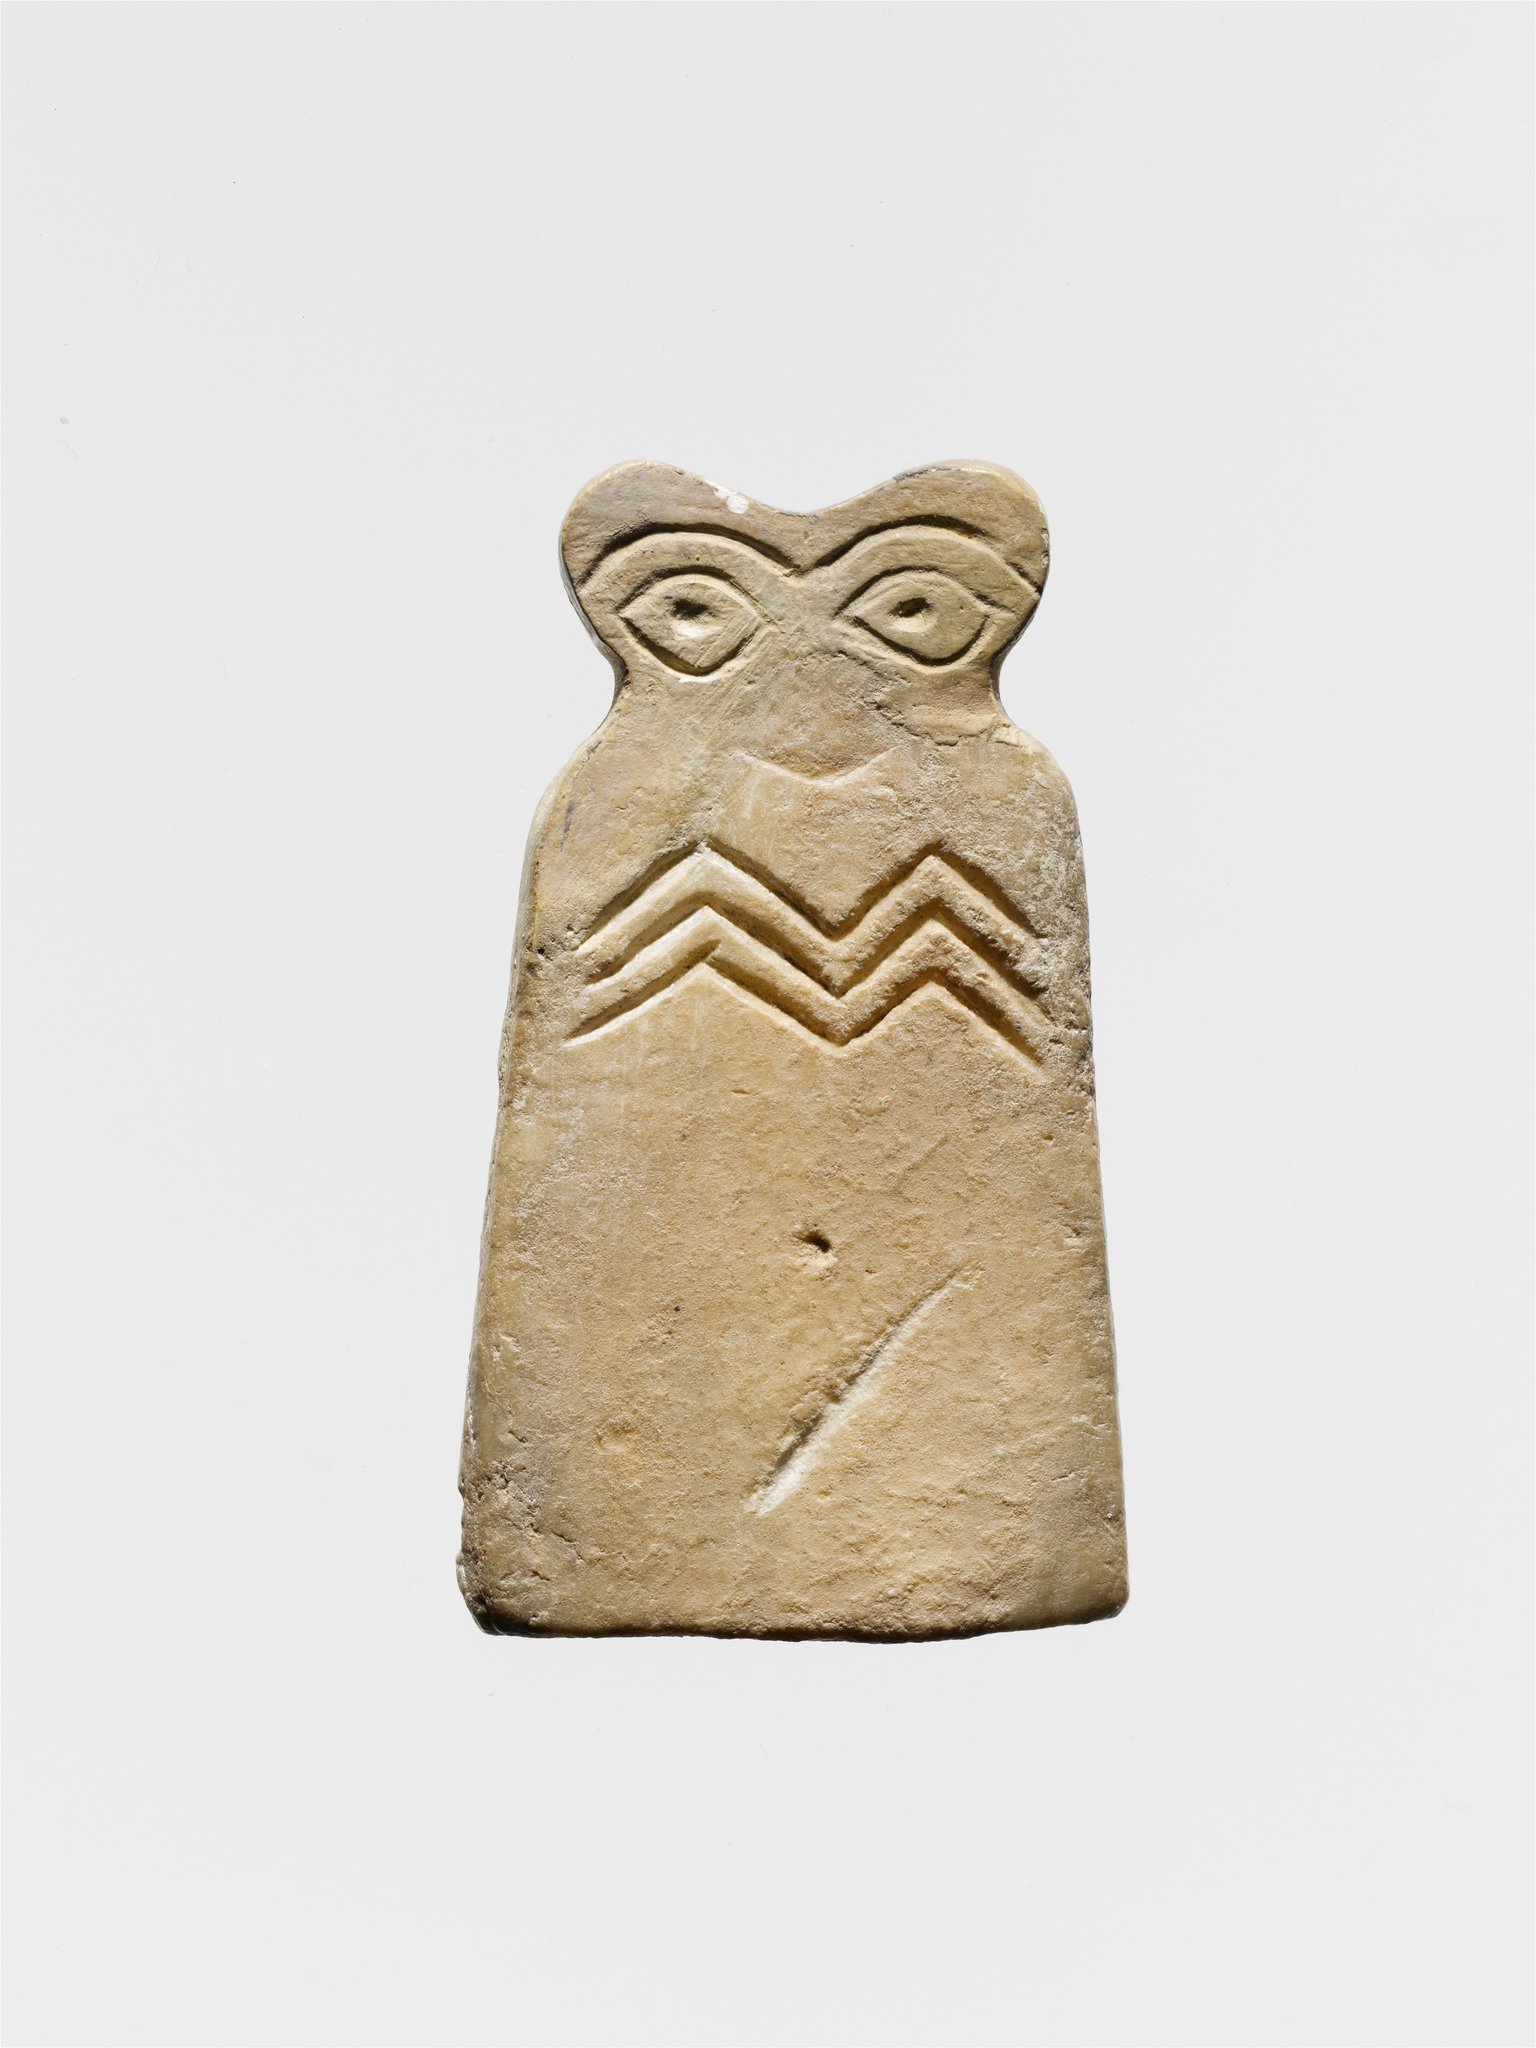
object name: sculpture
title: Eye idol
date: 3700-3500 BCE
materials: alabaster, gypsum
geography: syria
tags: eyes